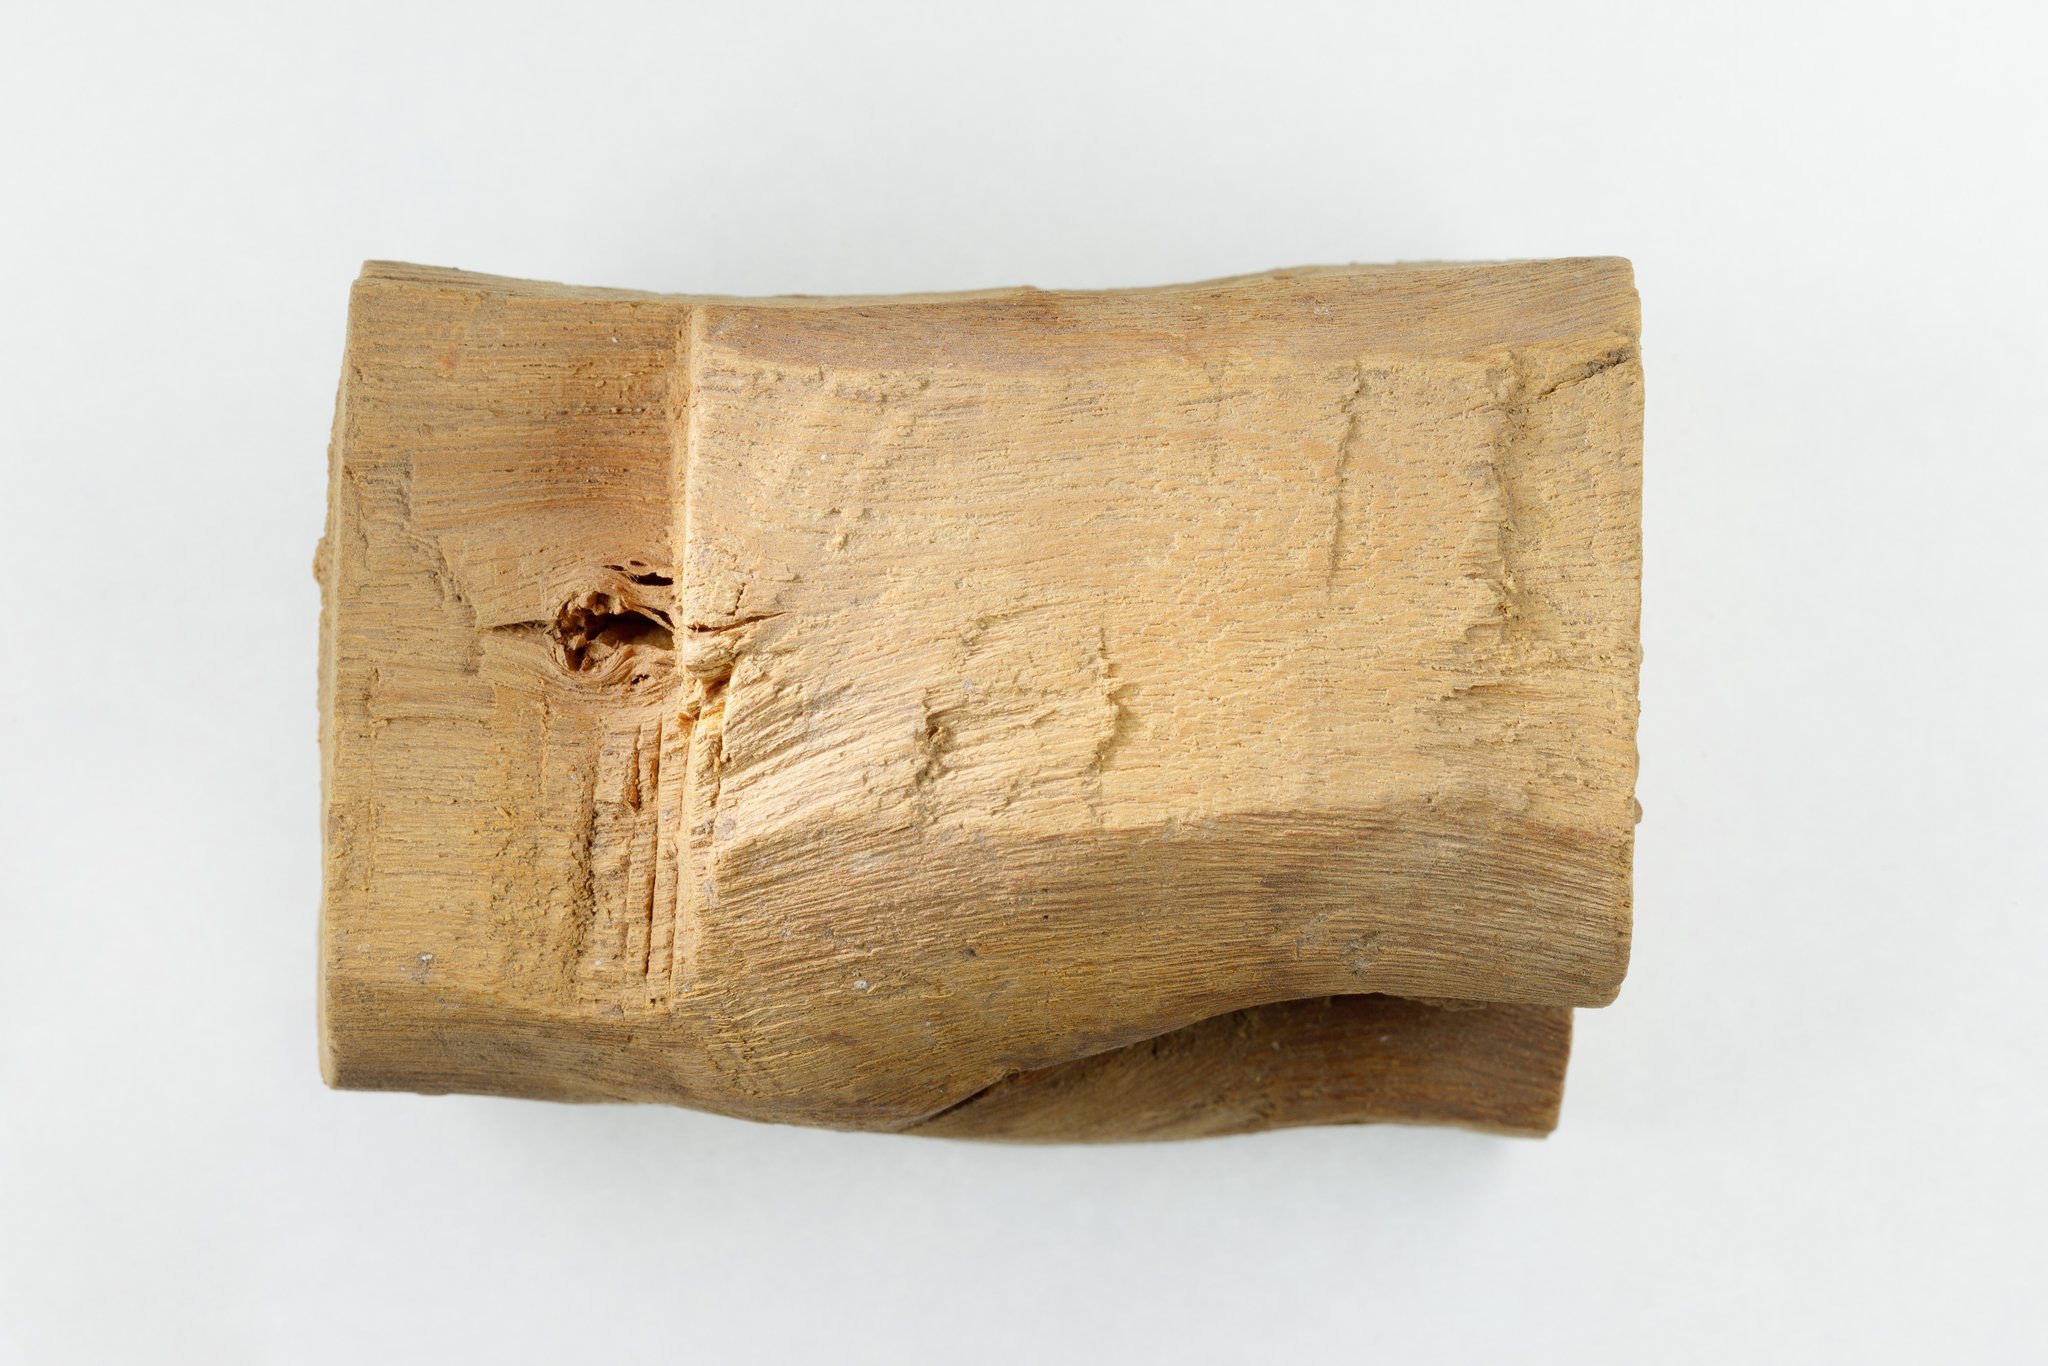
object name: block, model, tool, senenmut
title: Model Tool from a Foundation Deposit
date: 1479-1458 BCE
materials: wood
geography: egypt